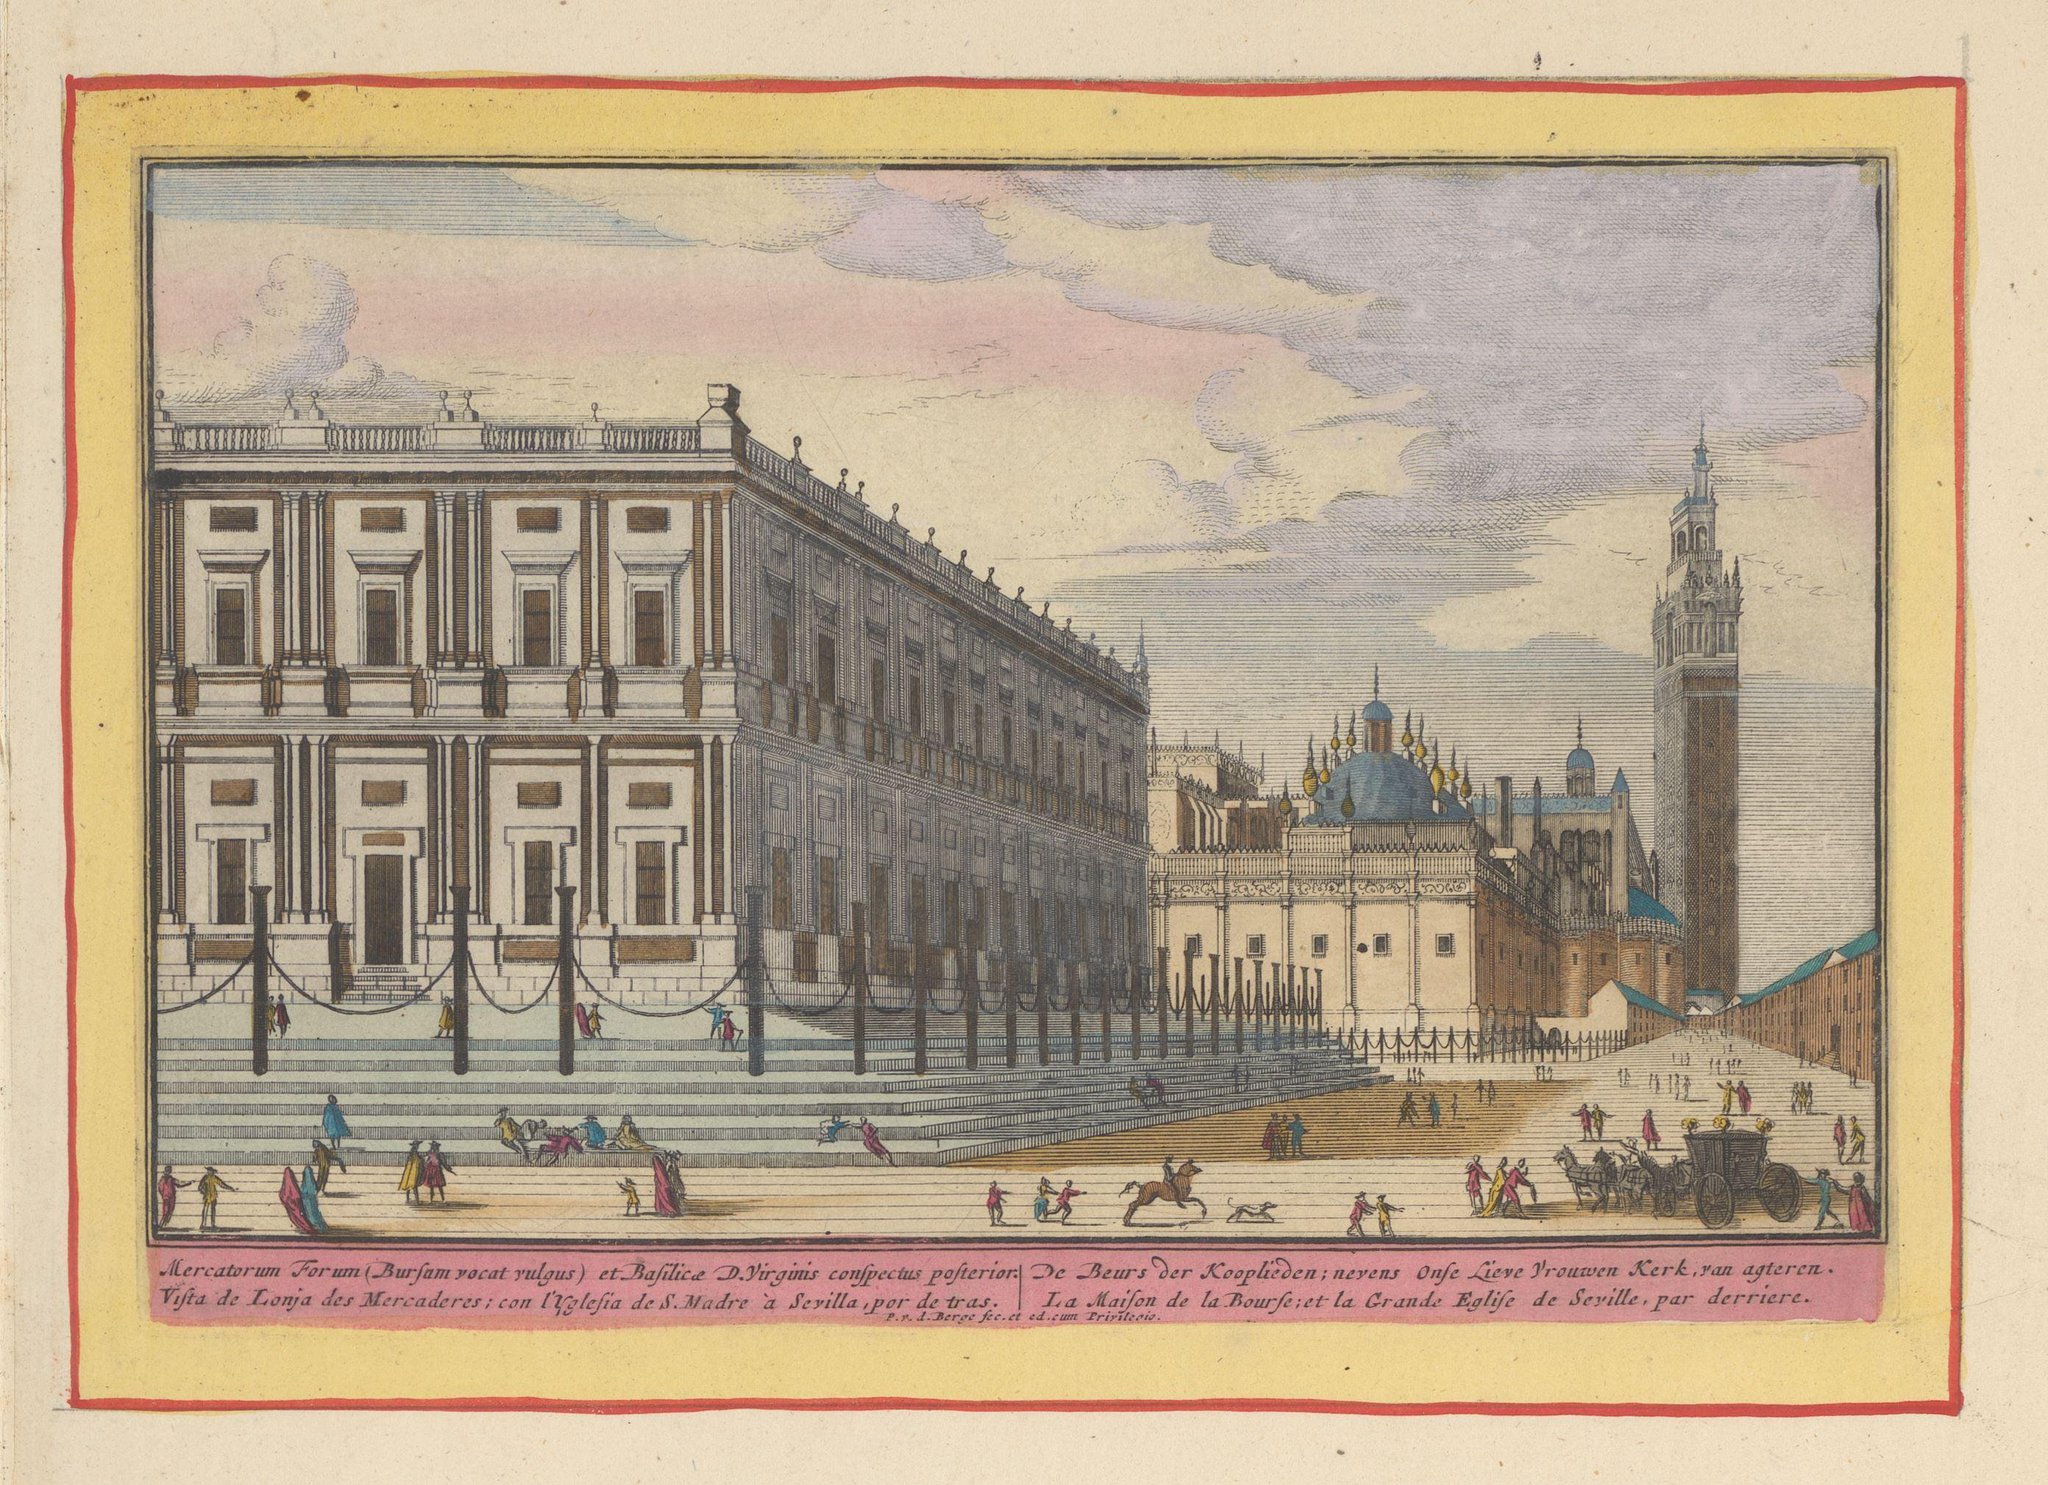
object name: print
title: Theatrum Hispaniae (...)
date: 1694-1737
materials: paper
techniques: etching, hand coloring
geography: the hague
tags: stock exchange, stock-market, church (exterior)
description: Gezicht op de beurs te Sevilla. Op de achtergrond de kathedraal en de toren Giralda. Onder de voorstelling een titel in het Latijn, Spaans, Nederlands en Frans. Prent maakt deel uit van een album.